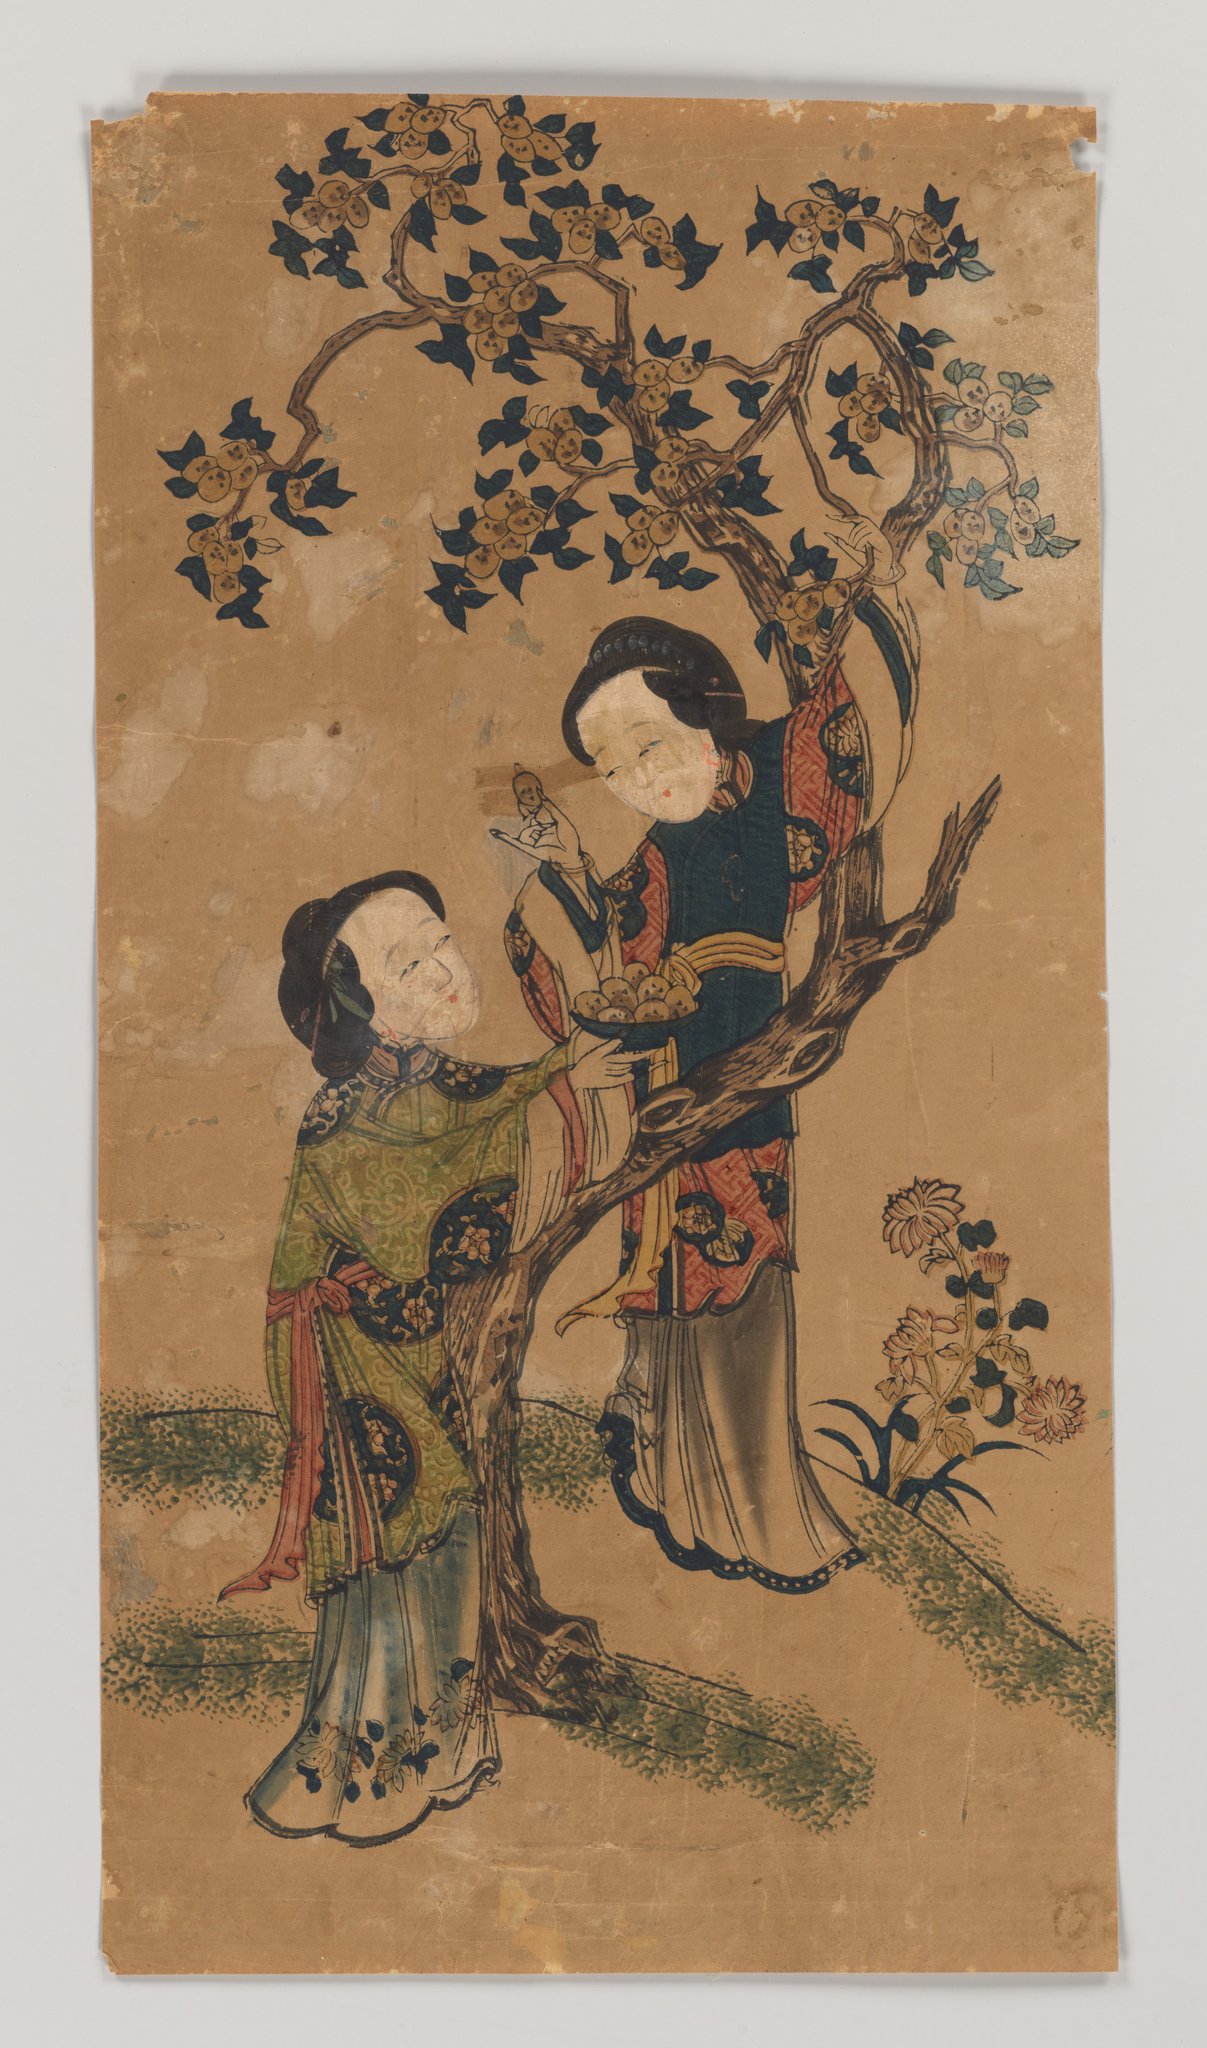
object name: print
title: Two Beauties Picking Dates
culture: chinese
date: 1736-1795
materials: ink, paper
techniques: hand coloring, woodblock print